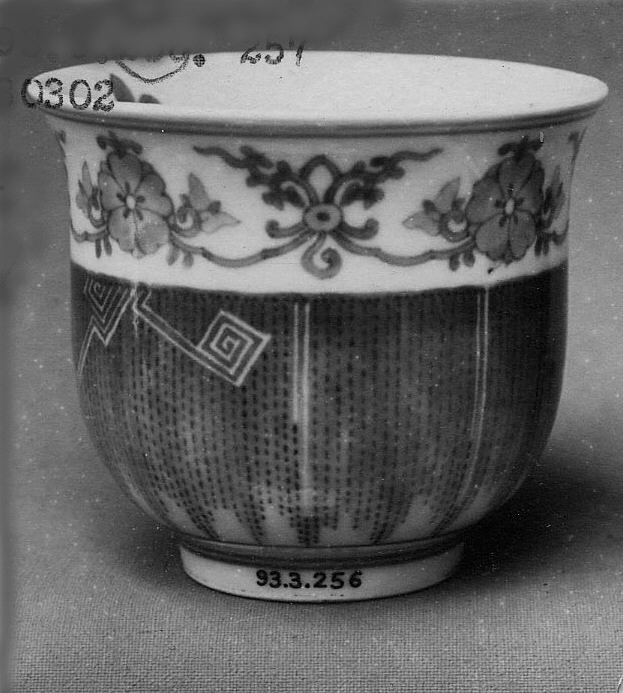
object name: cup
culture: japanese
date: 1800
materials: glaze, porcelain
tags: flowers